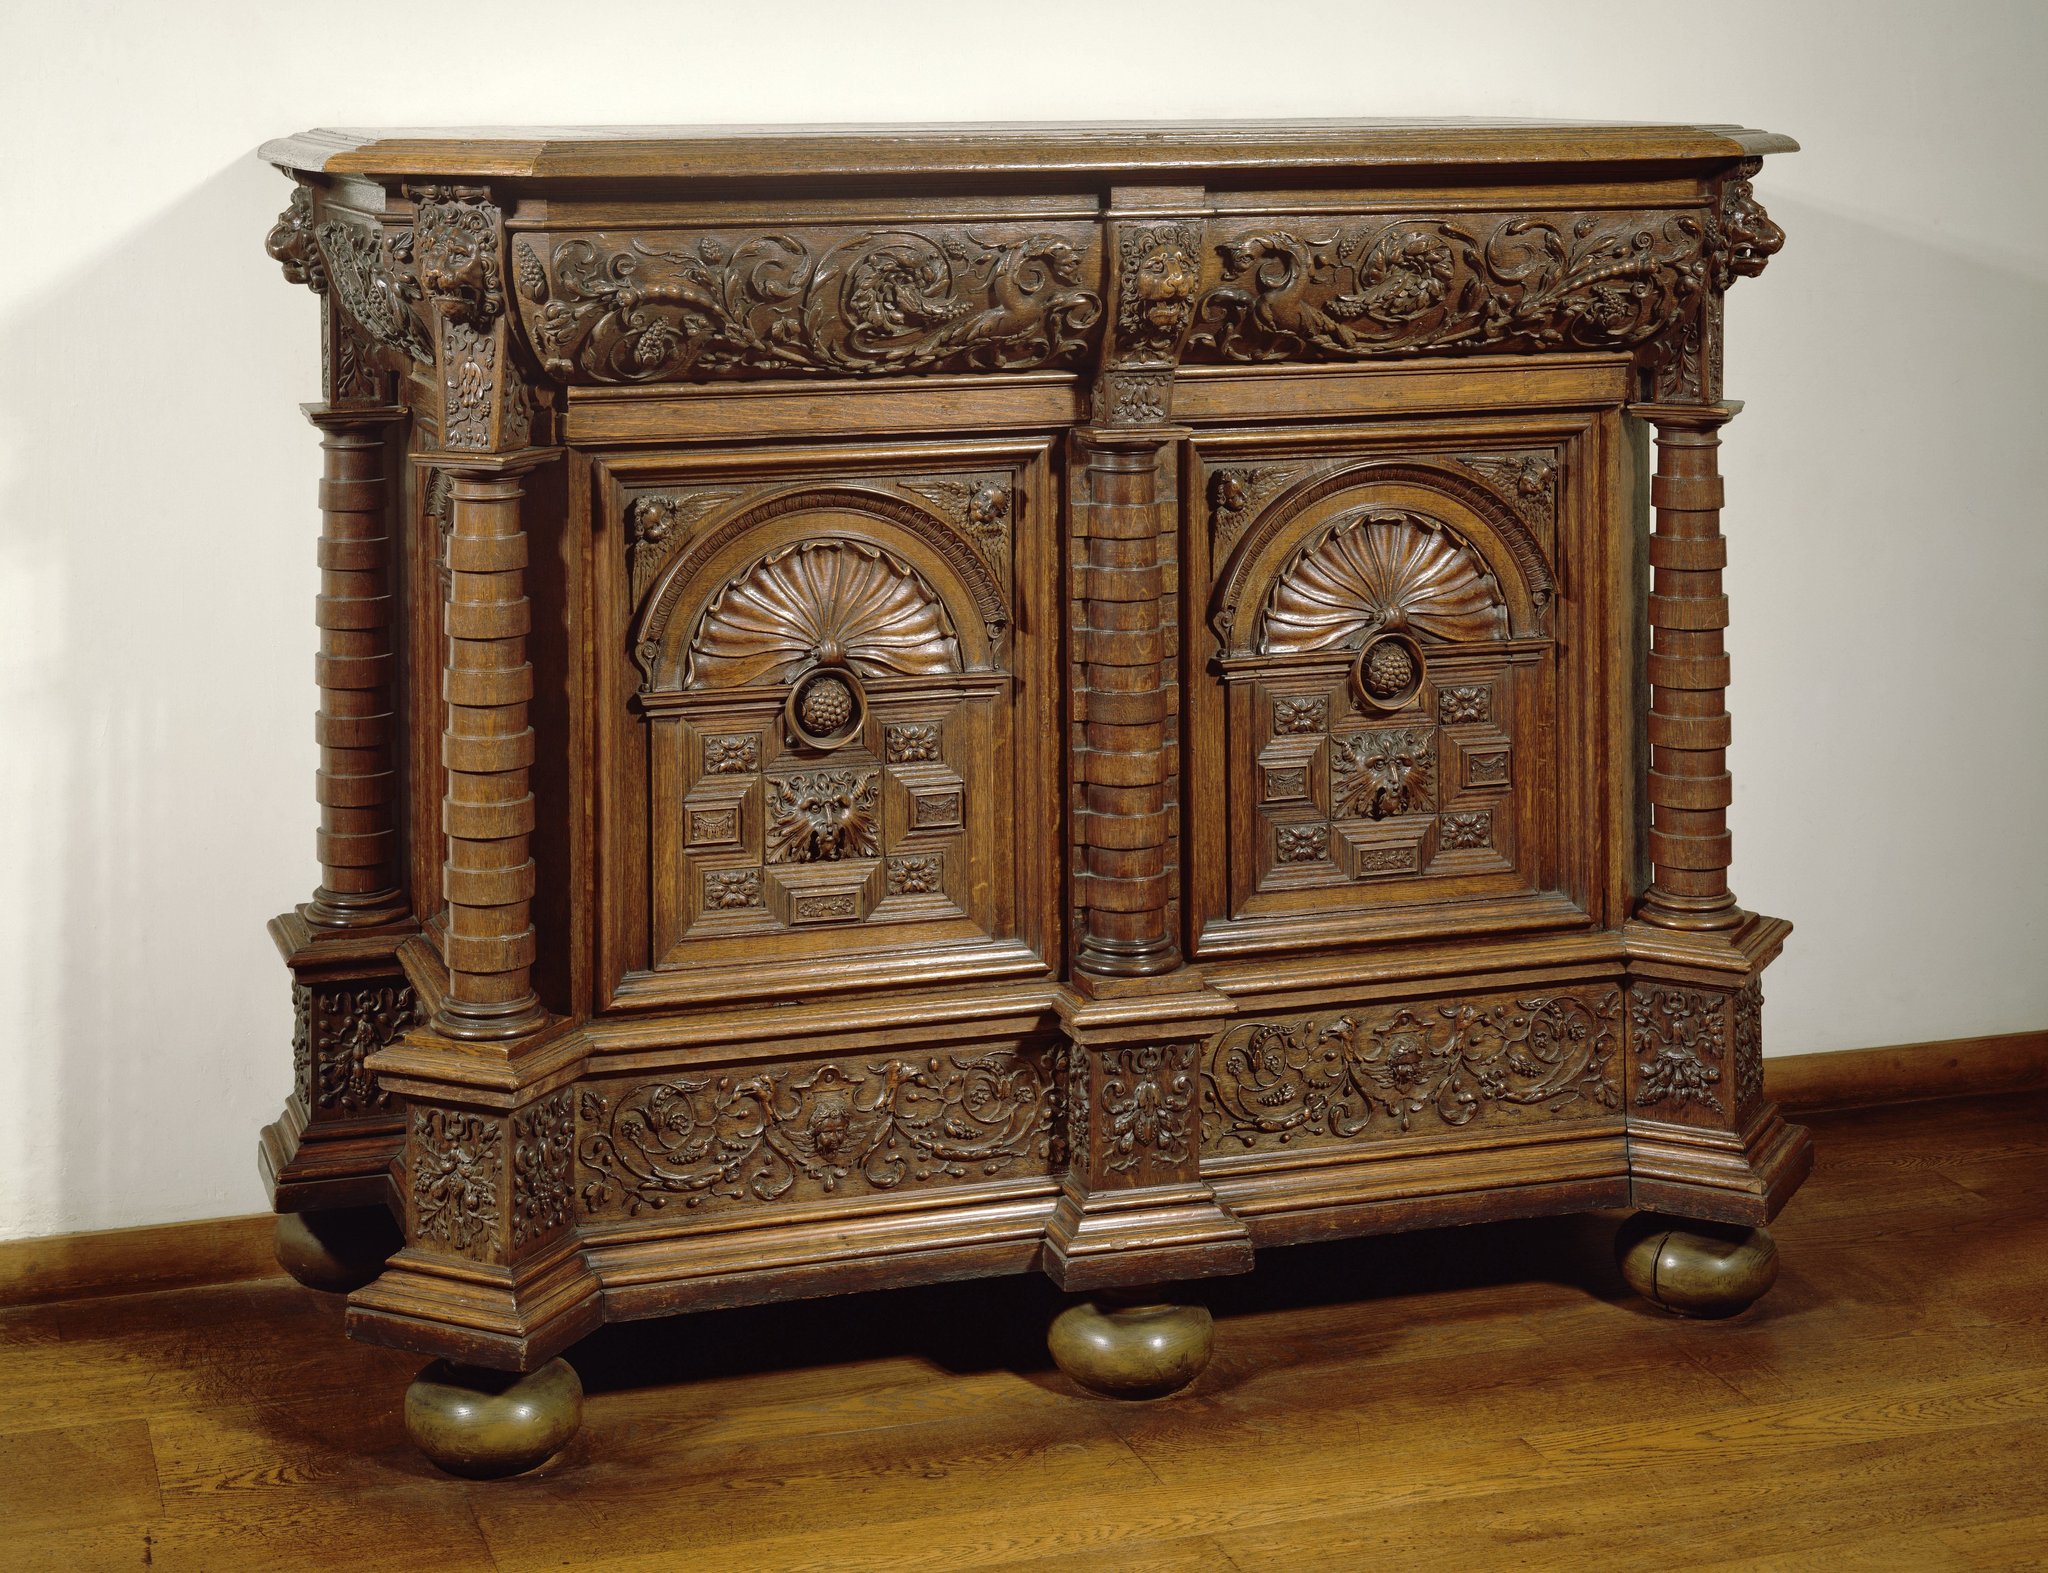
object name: case furniture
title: Kast met hoekstijlen in de vorm van half vrijstaande Toscaanse zuilen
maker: Anonymous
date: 1600-1650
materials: wood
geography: southern netherlands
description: Cupboard. Oak. Southern Netherlands, c. 1620 - 1650.